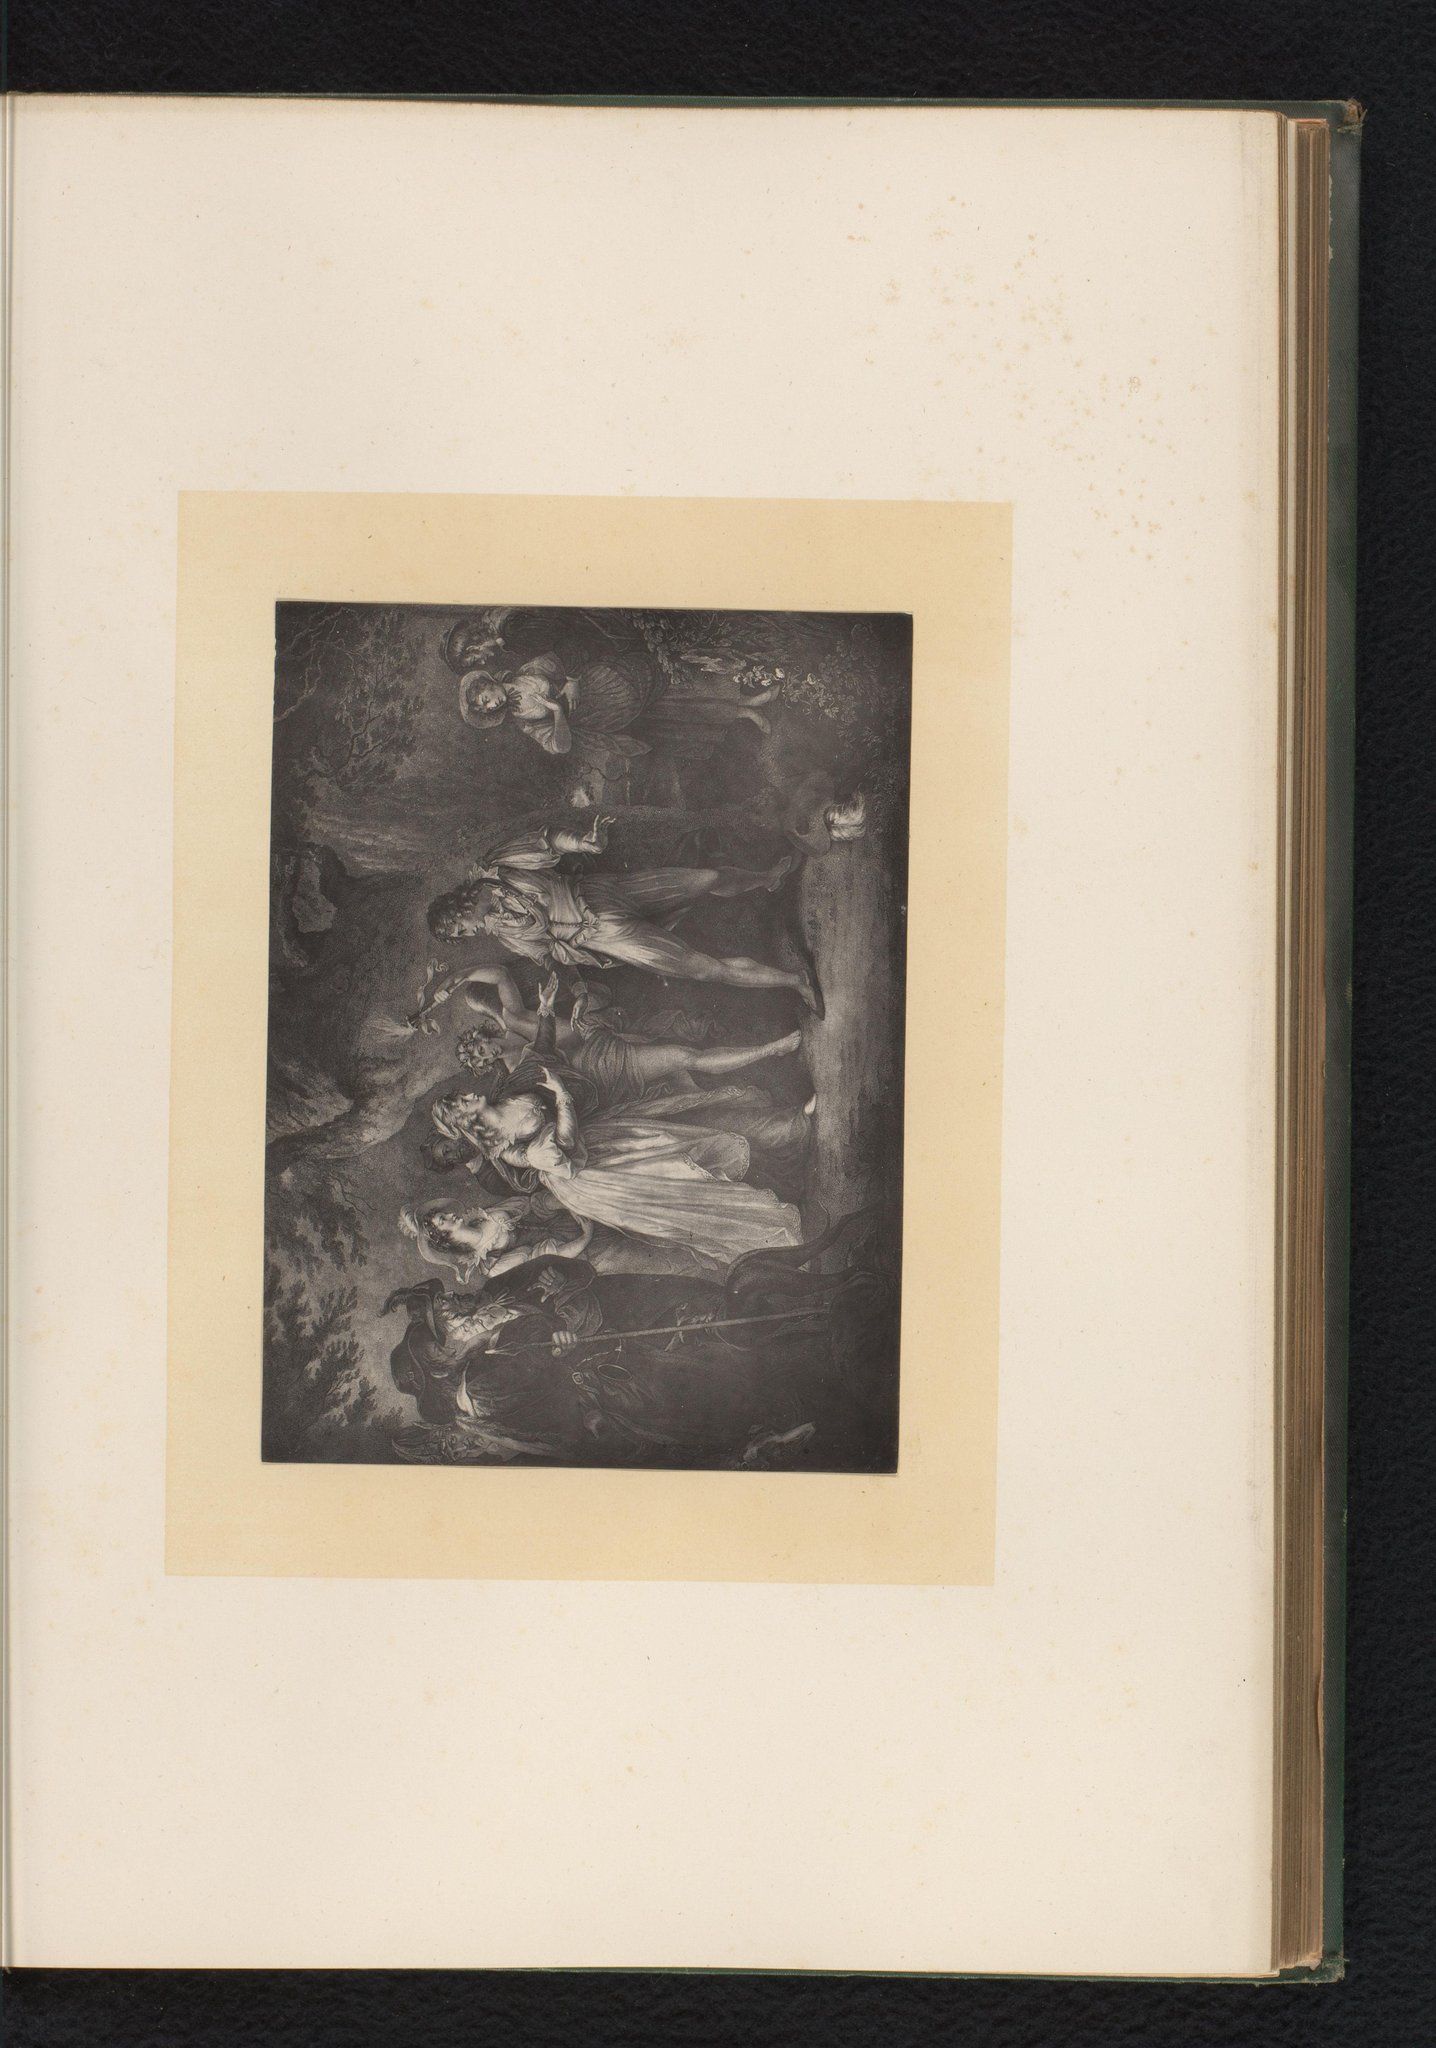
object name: page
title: As You Like It, Act V, Scene 4: A Forest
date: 1874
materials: paper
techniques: woodburytype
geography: london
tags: (shakespeare, as you like it) specific works of literature (with author, title)